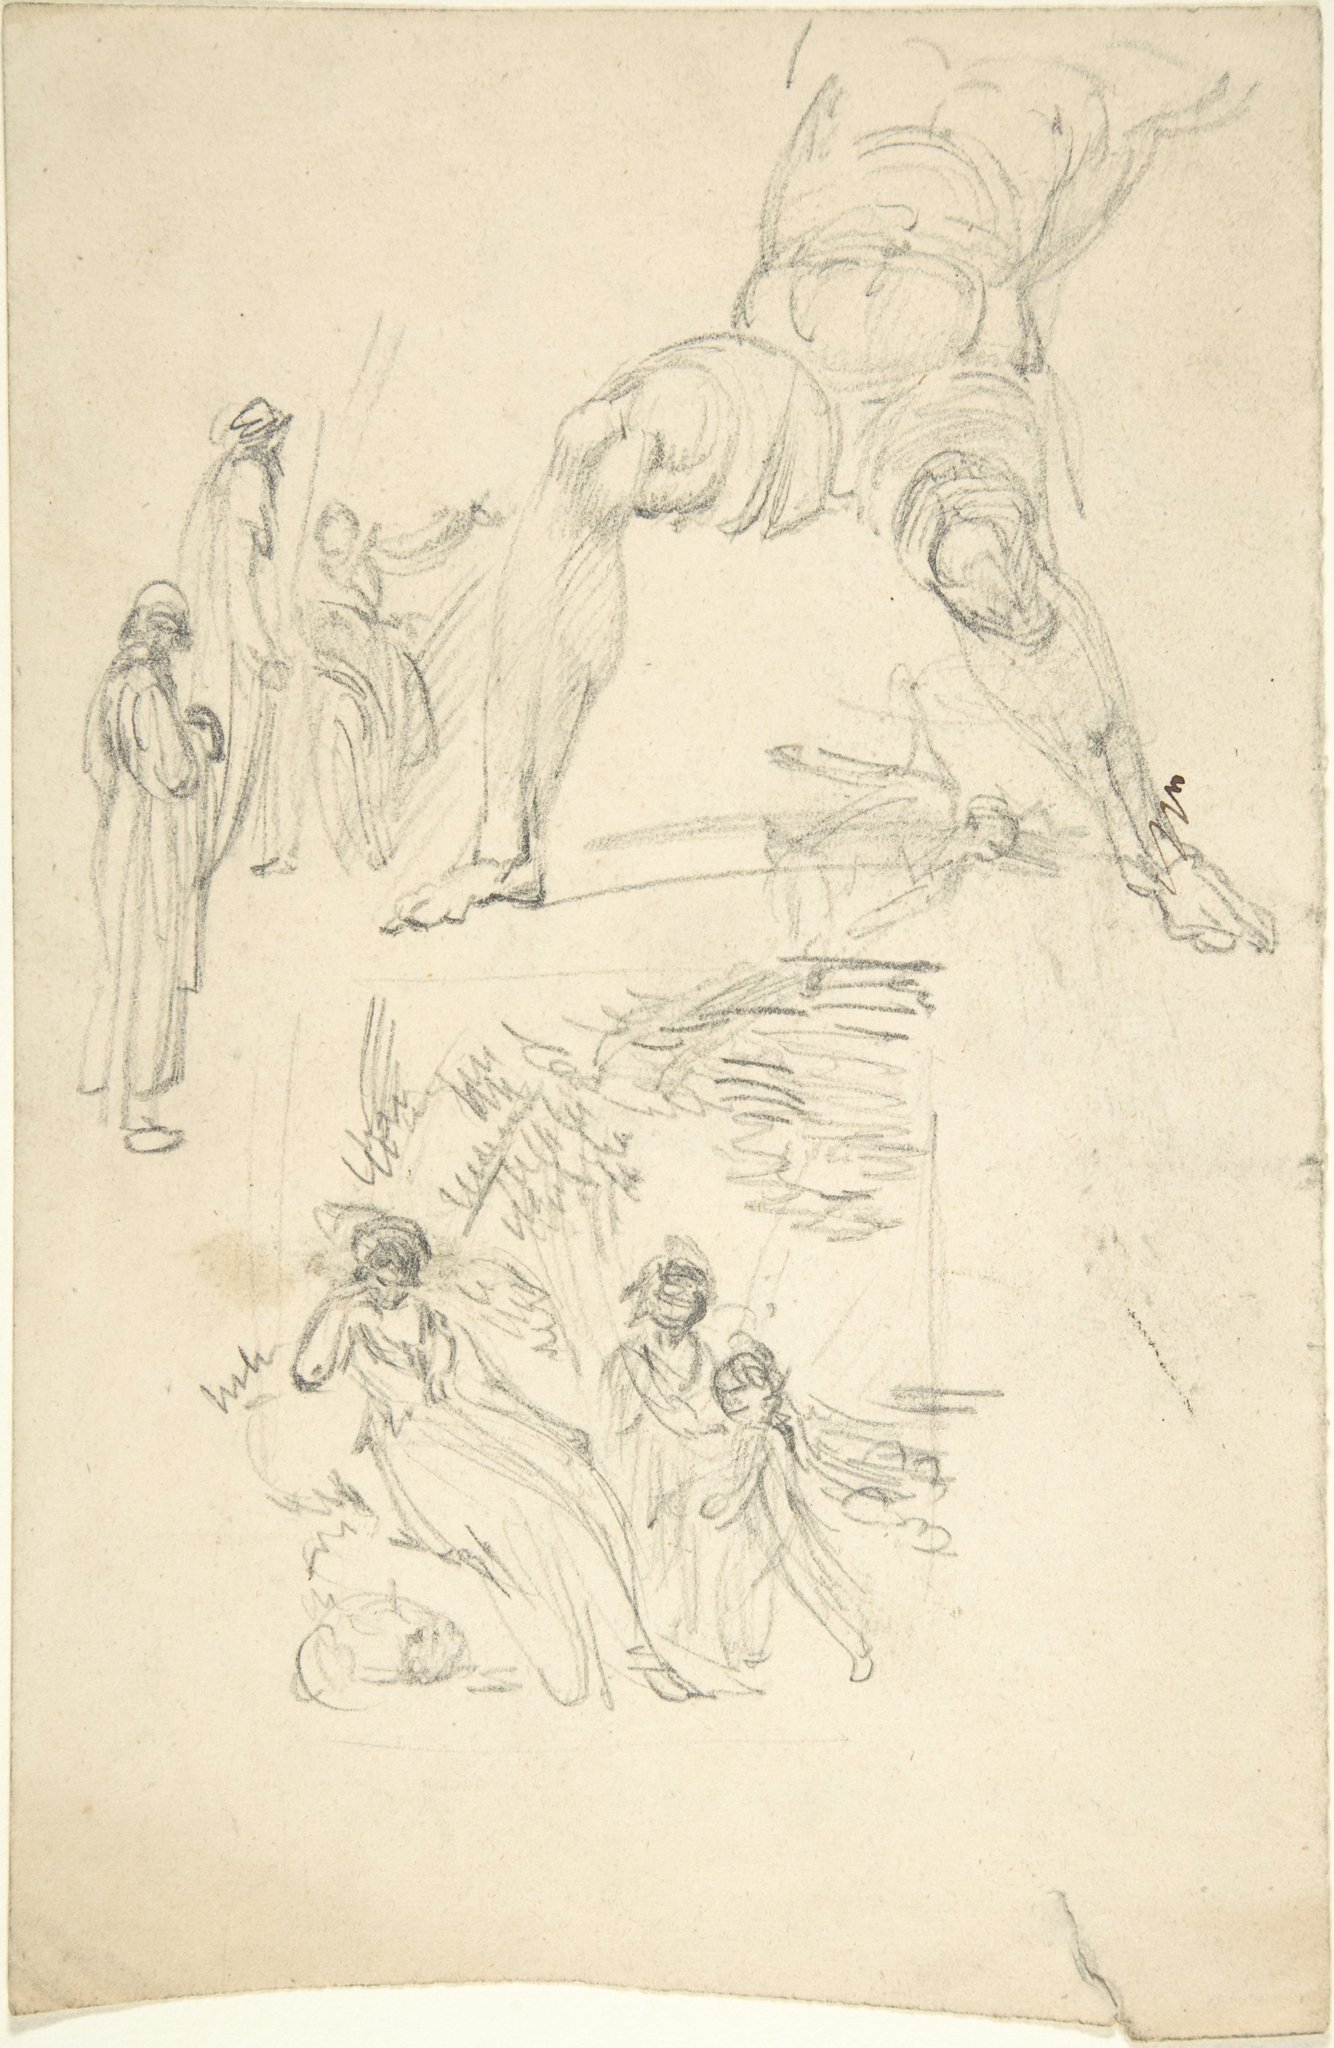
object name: drawing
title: Sketchbook Page: Figures and Sculpture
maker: anonymous, british, 19th century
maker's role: artist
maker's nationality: british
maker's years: 1800-1900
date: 1801-1900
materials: graphite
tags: human figures,sculpture